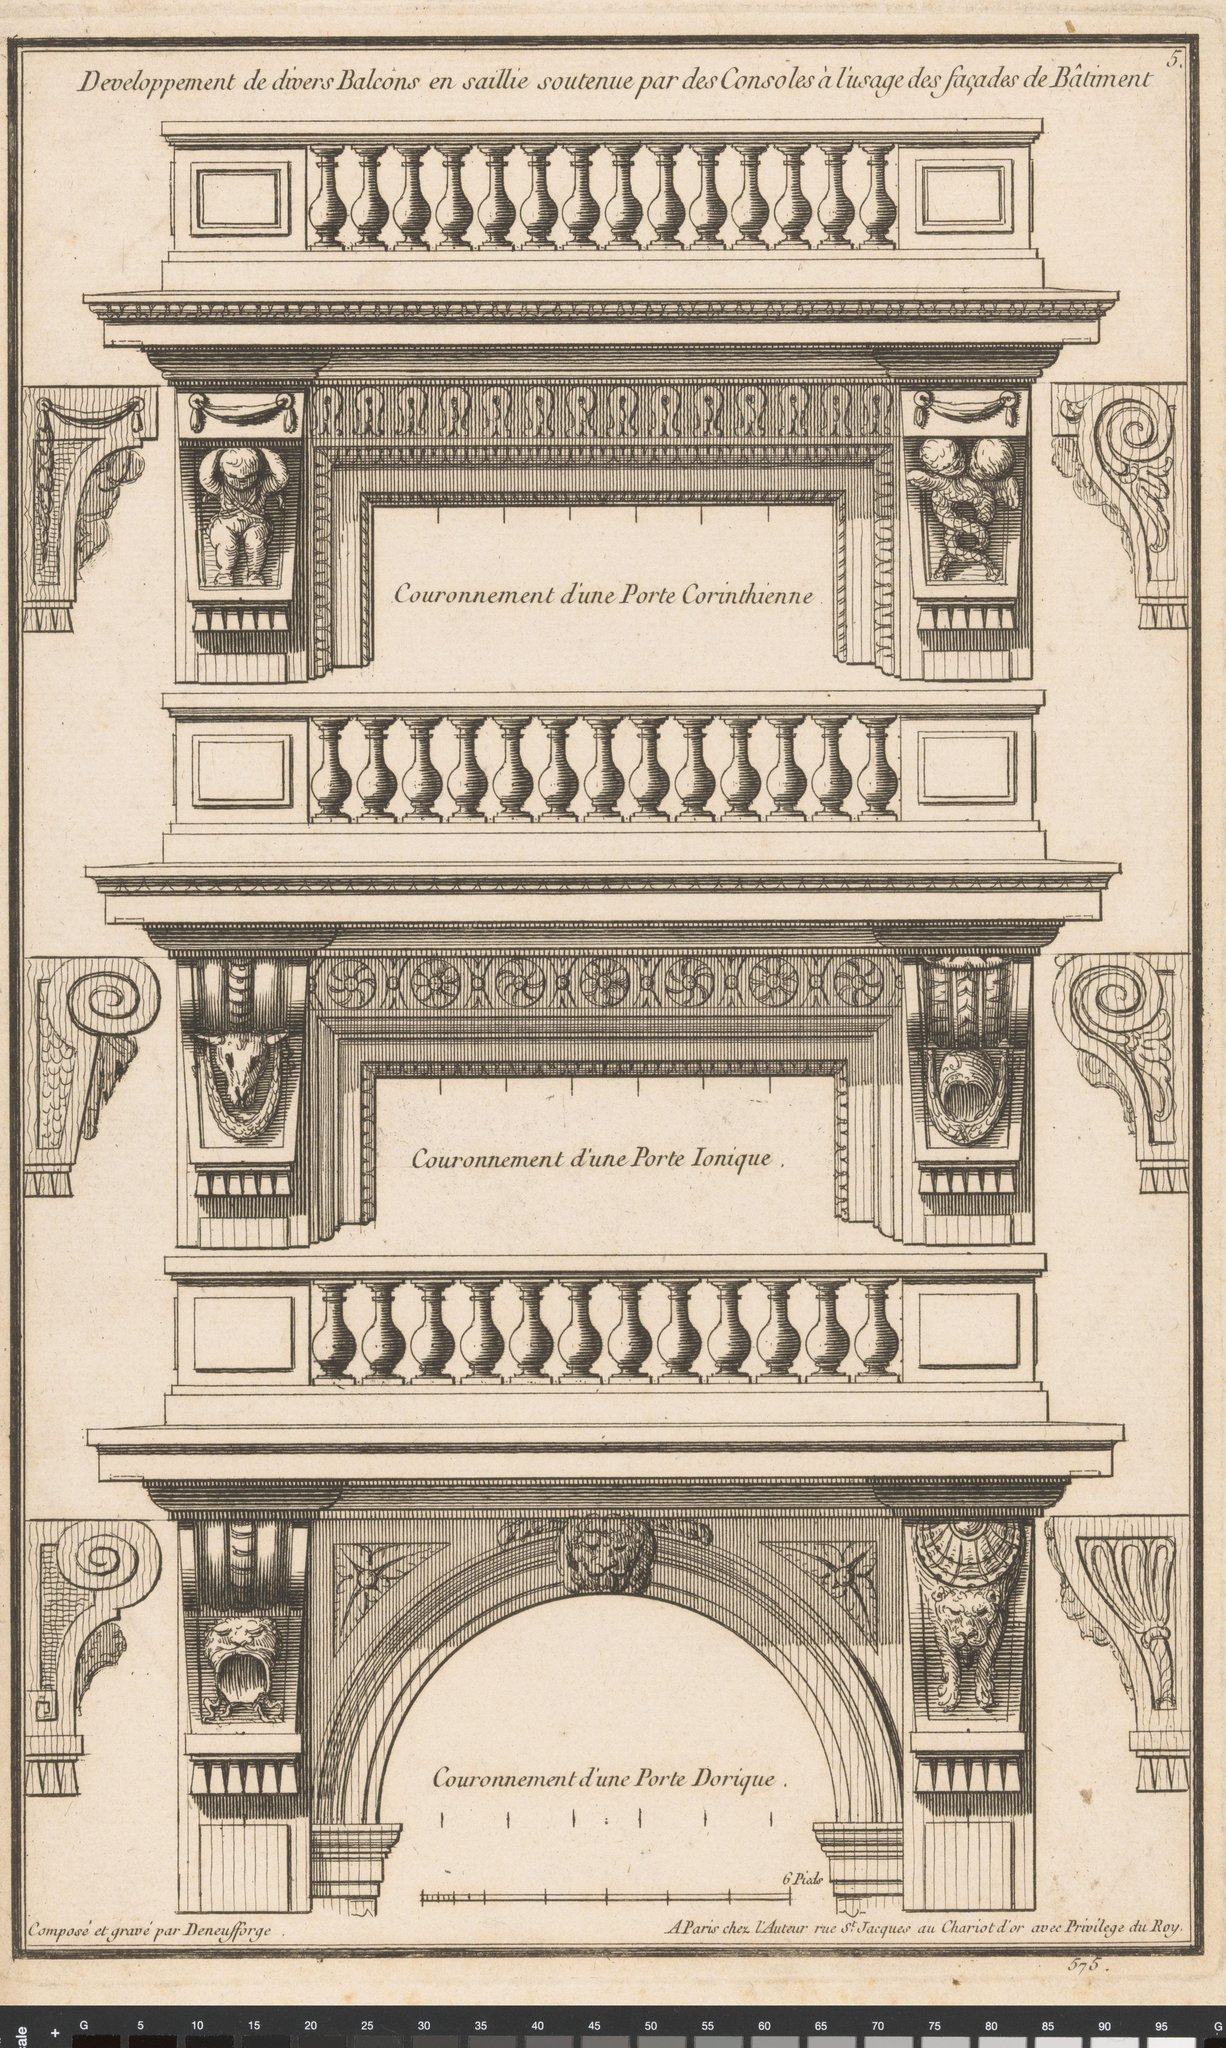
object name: ornament print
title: Huitième Volume, Recueil élémentaire d'architecture (...)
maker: jean françois de neufforge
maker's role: print maker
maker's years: 1714-1791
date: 1767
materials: paper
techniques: etching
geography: paris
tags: other architectural details (console), balcony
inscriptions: collector's mark: Lugt 2228, collector's mark: Lugt 2760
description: Drie geornamenteerde balkons met balusters en consoles met putti, bucranium, helmen en een leeuw. Prentnummer 575.